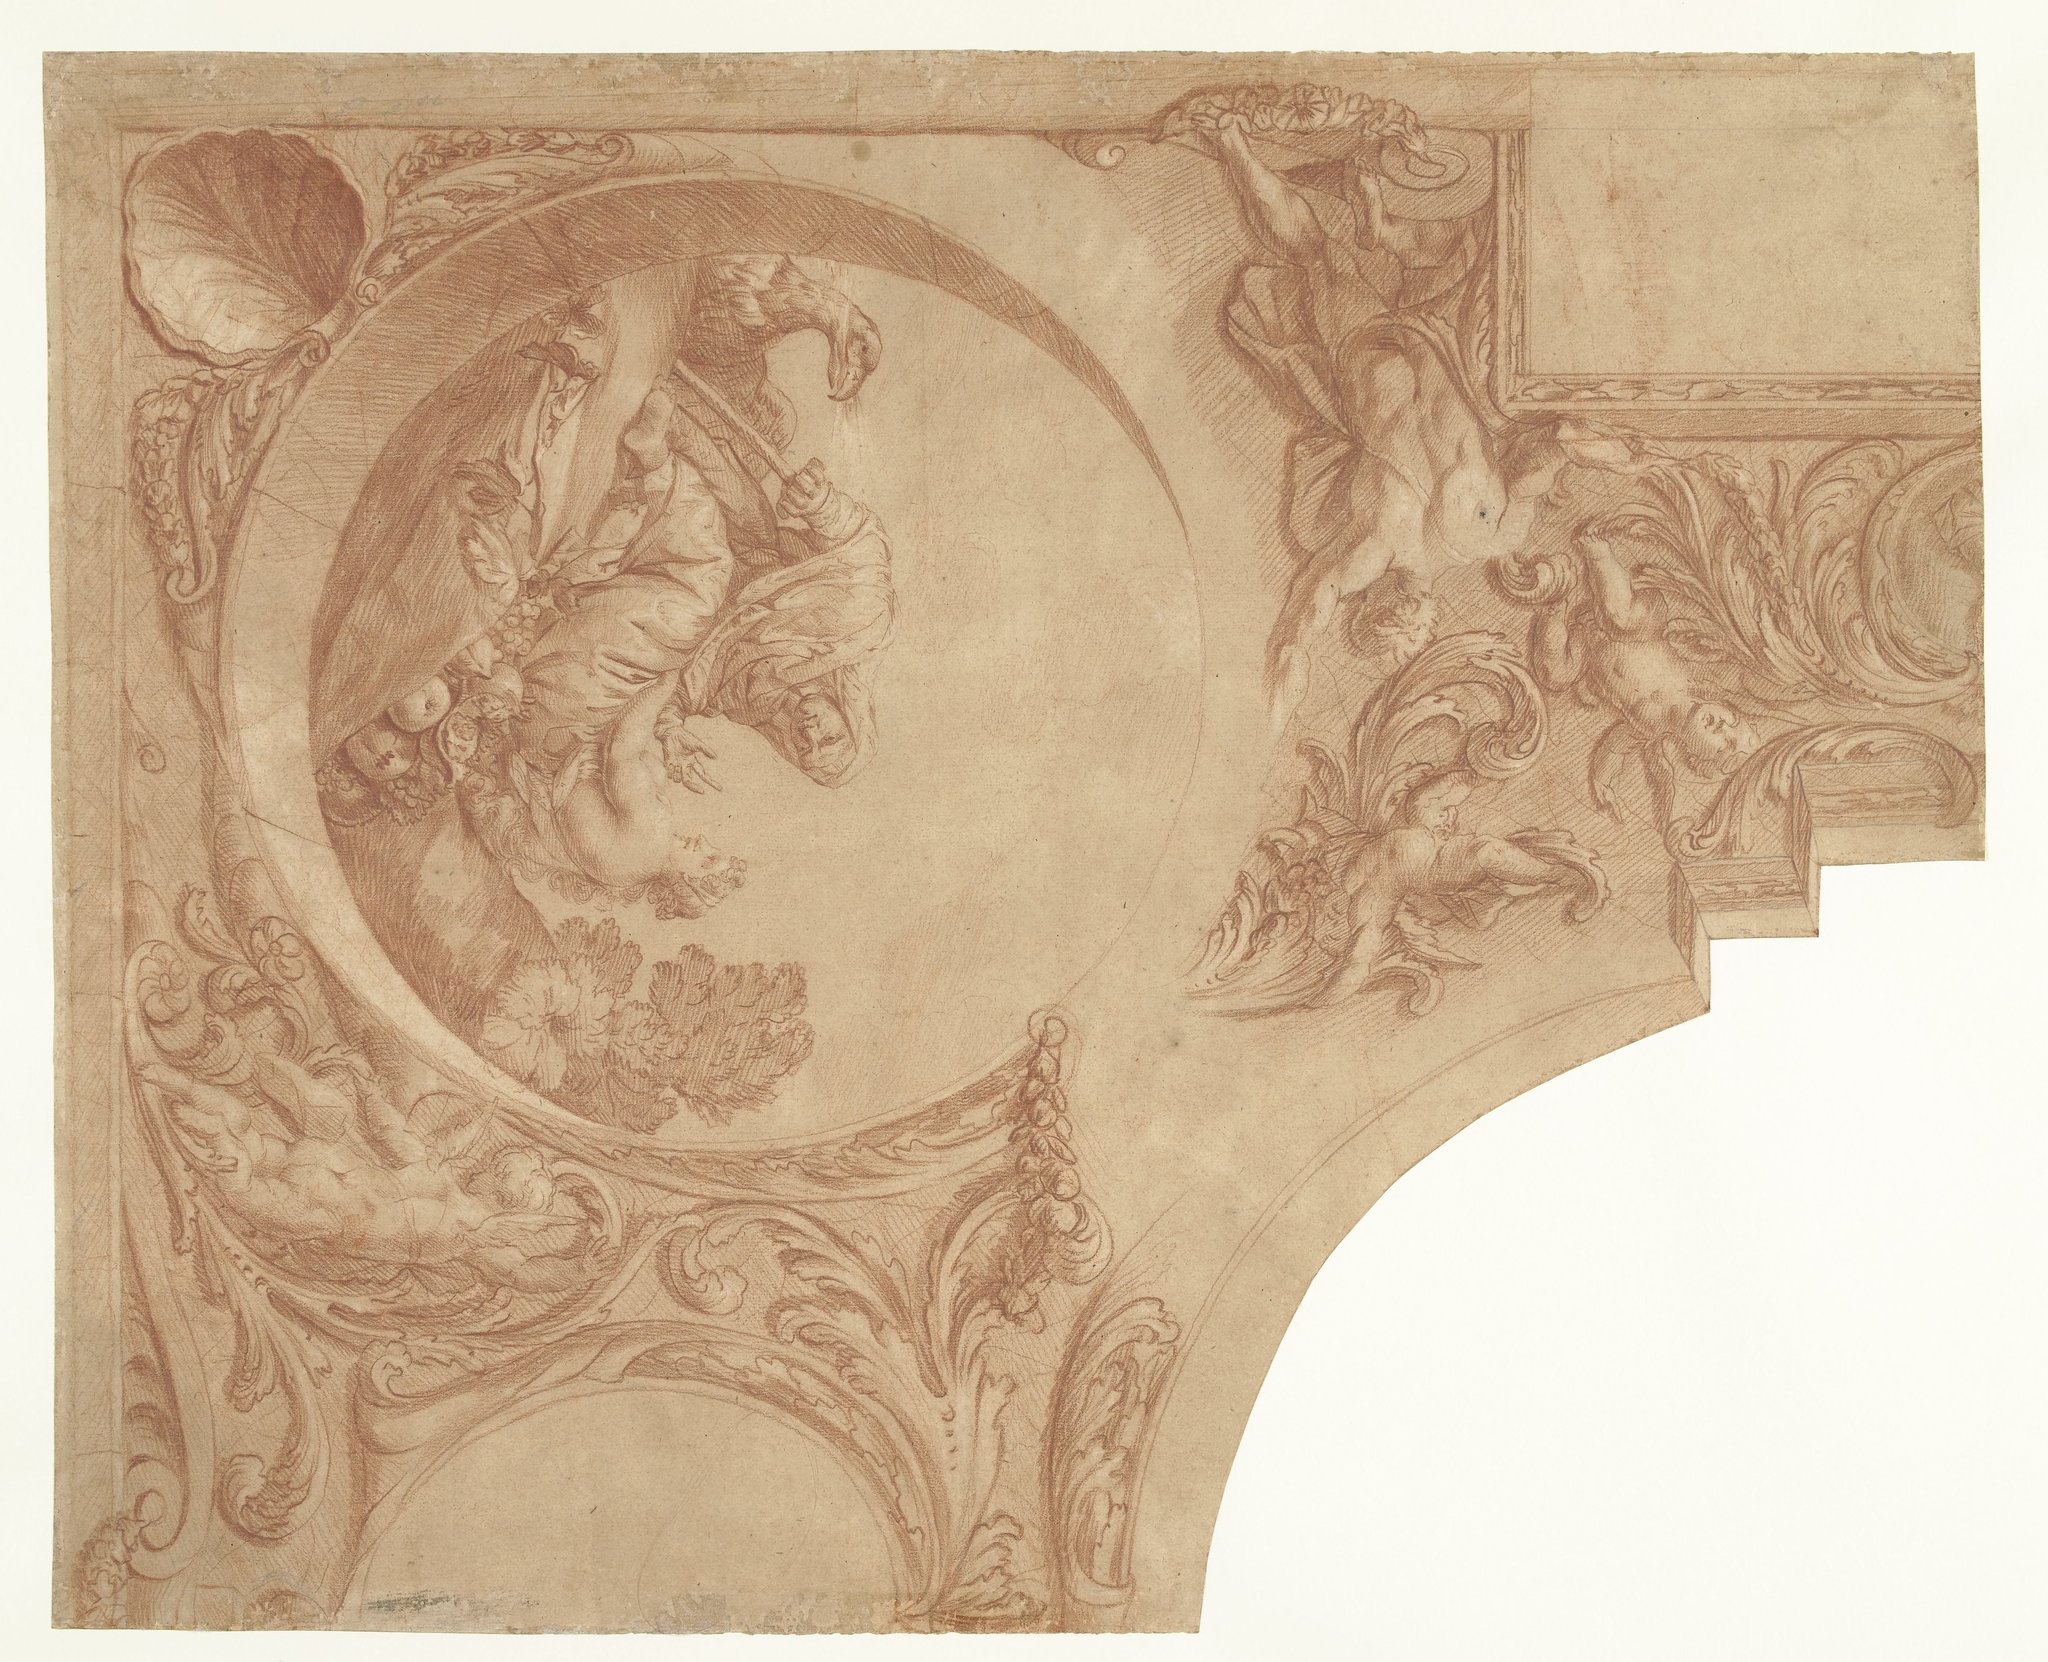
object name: drawing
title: Ontwerp voor een hoekstuk van een plafond met Vertumnus en Pomona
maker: mattheus terwesten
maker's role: draughtsman, painter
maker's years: 1670-1757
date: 1680-1757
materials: chalk, paper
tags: vertumnus and pomona, acanthus ~ ornament, (decorated) ceiling, cupids: 'amores', 'amoretti', 'putti'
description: Hoekstuk van een plafond met Vertumnus en Pomona in een ronde cartouche.